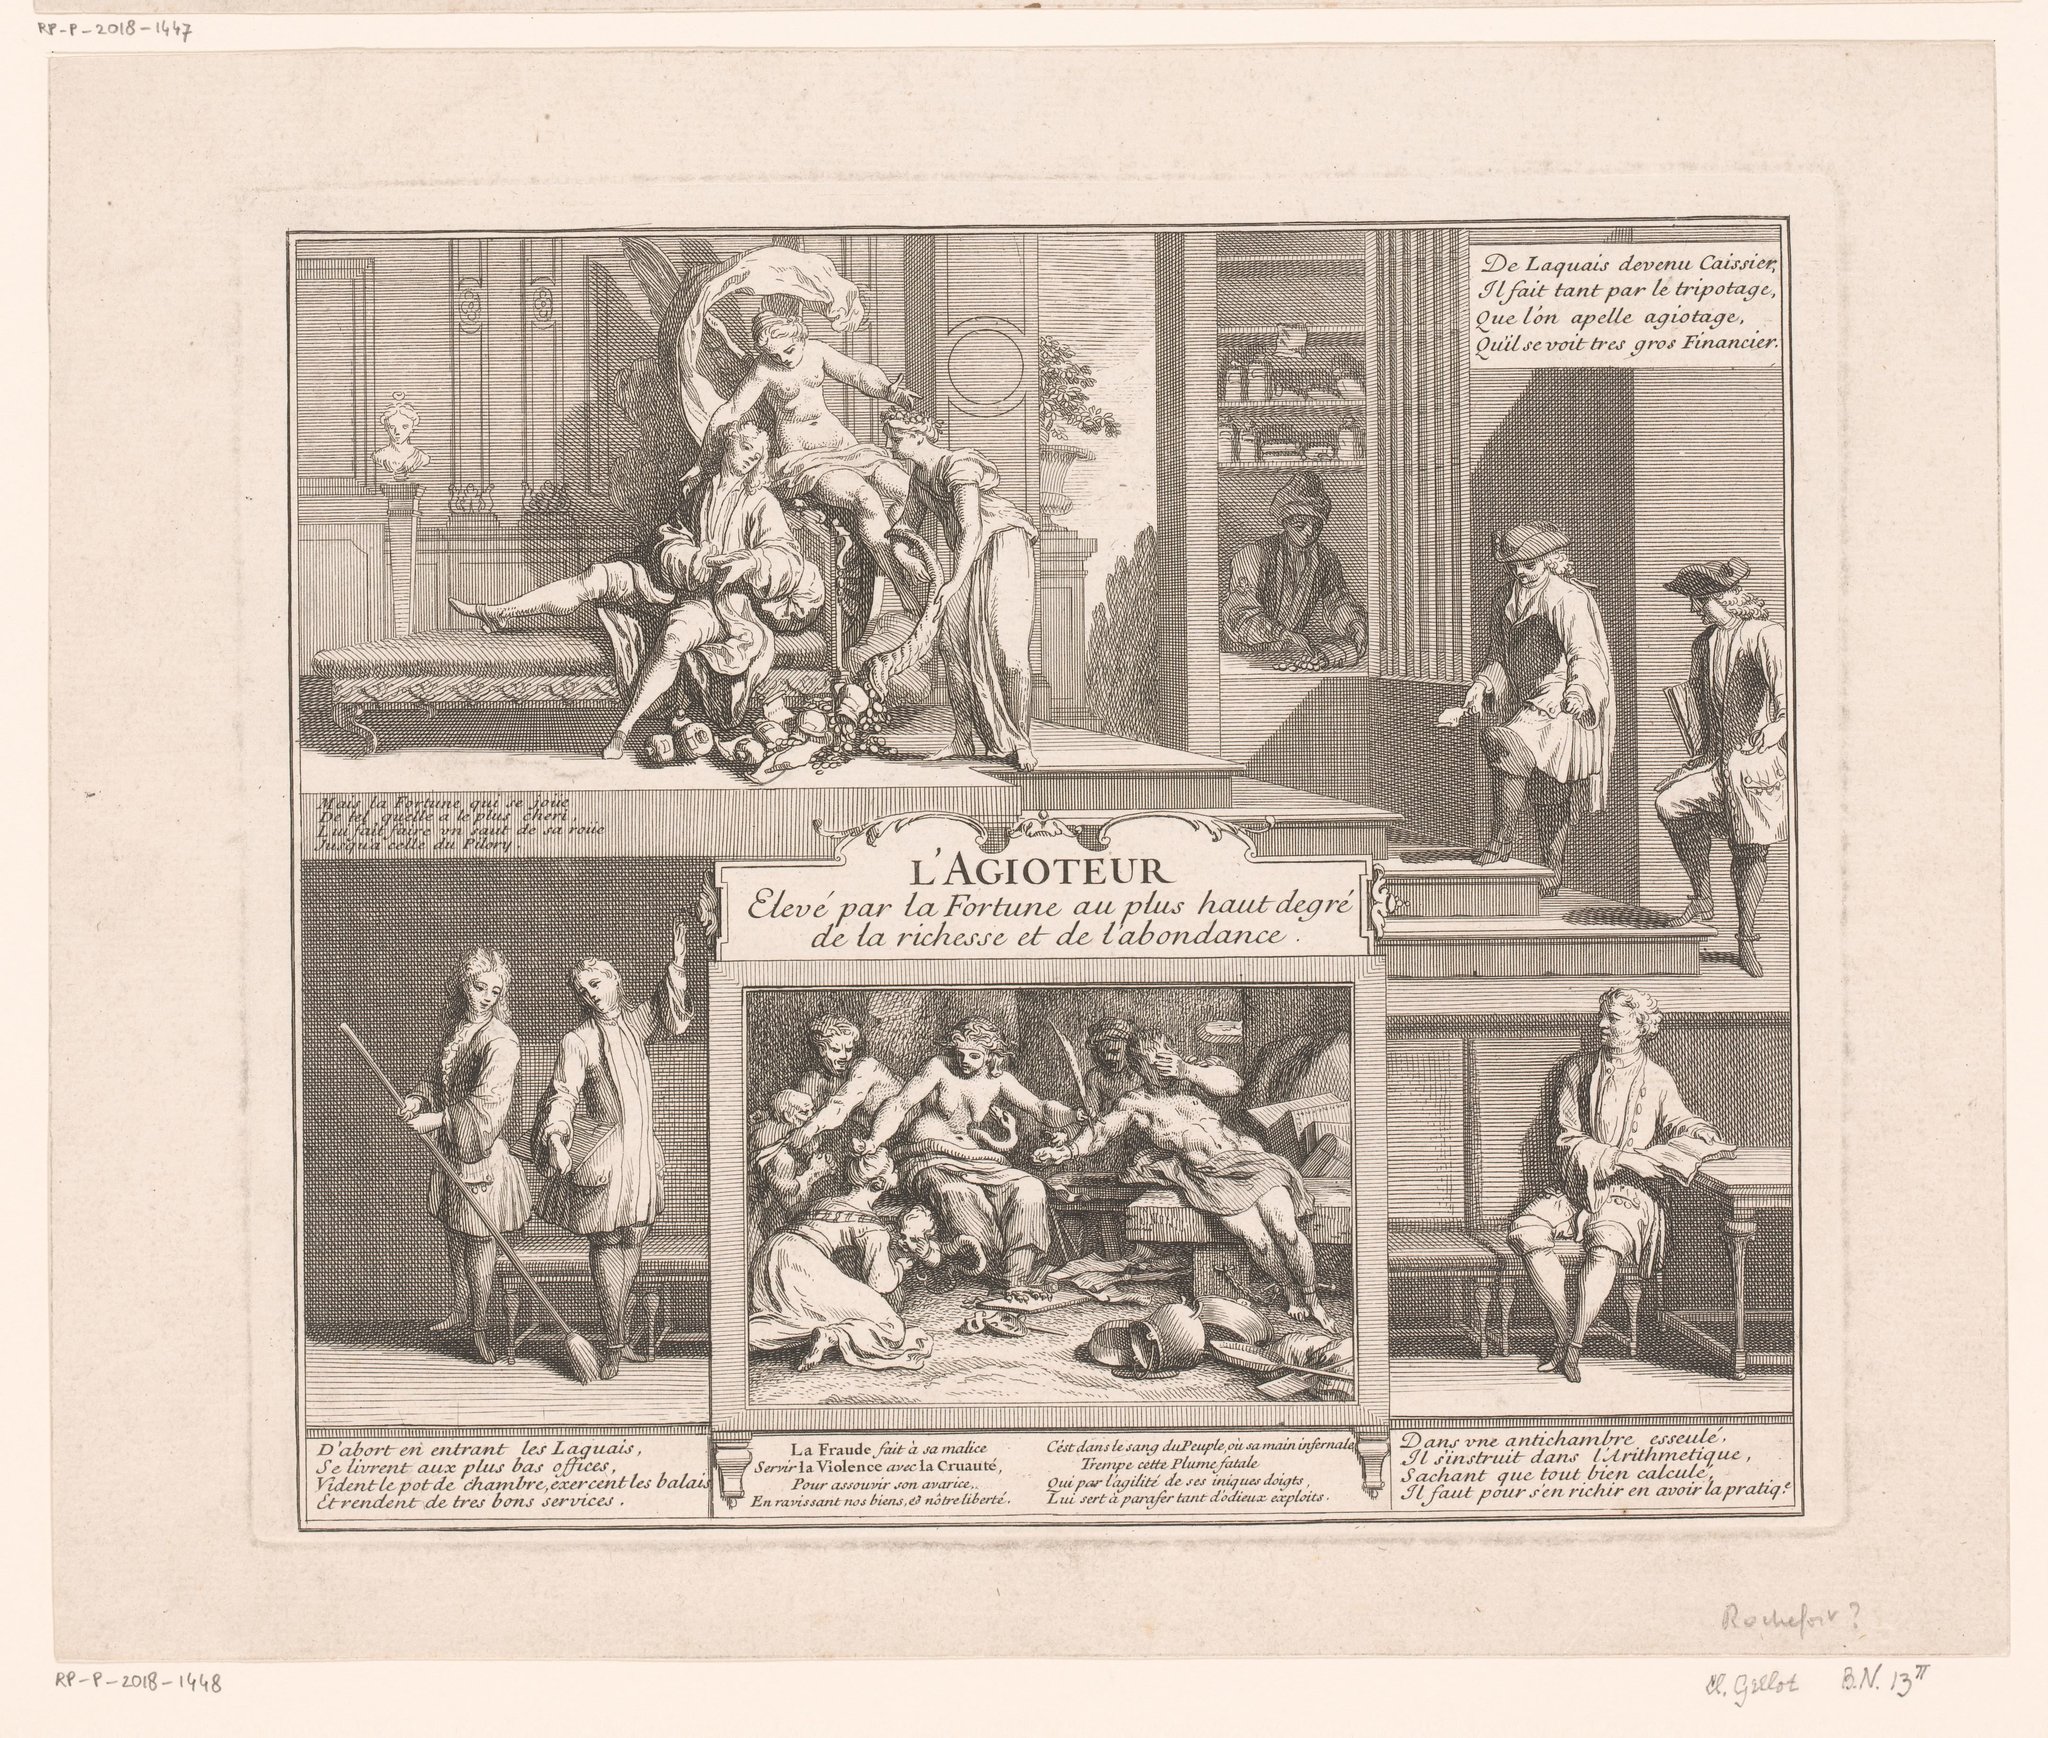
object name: print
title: Effectenhandelaar vergaart met behulp van Fortuna rijkdom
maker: claude gillot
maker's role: draughtsman, print maker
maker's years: 1673-1722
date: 1720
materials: paper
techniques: engraving, etching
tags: stock exchange, stock-market, fortuna as roman personification